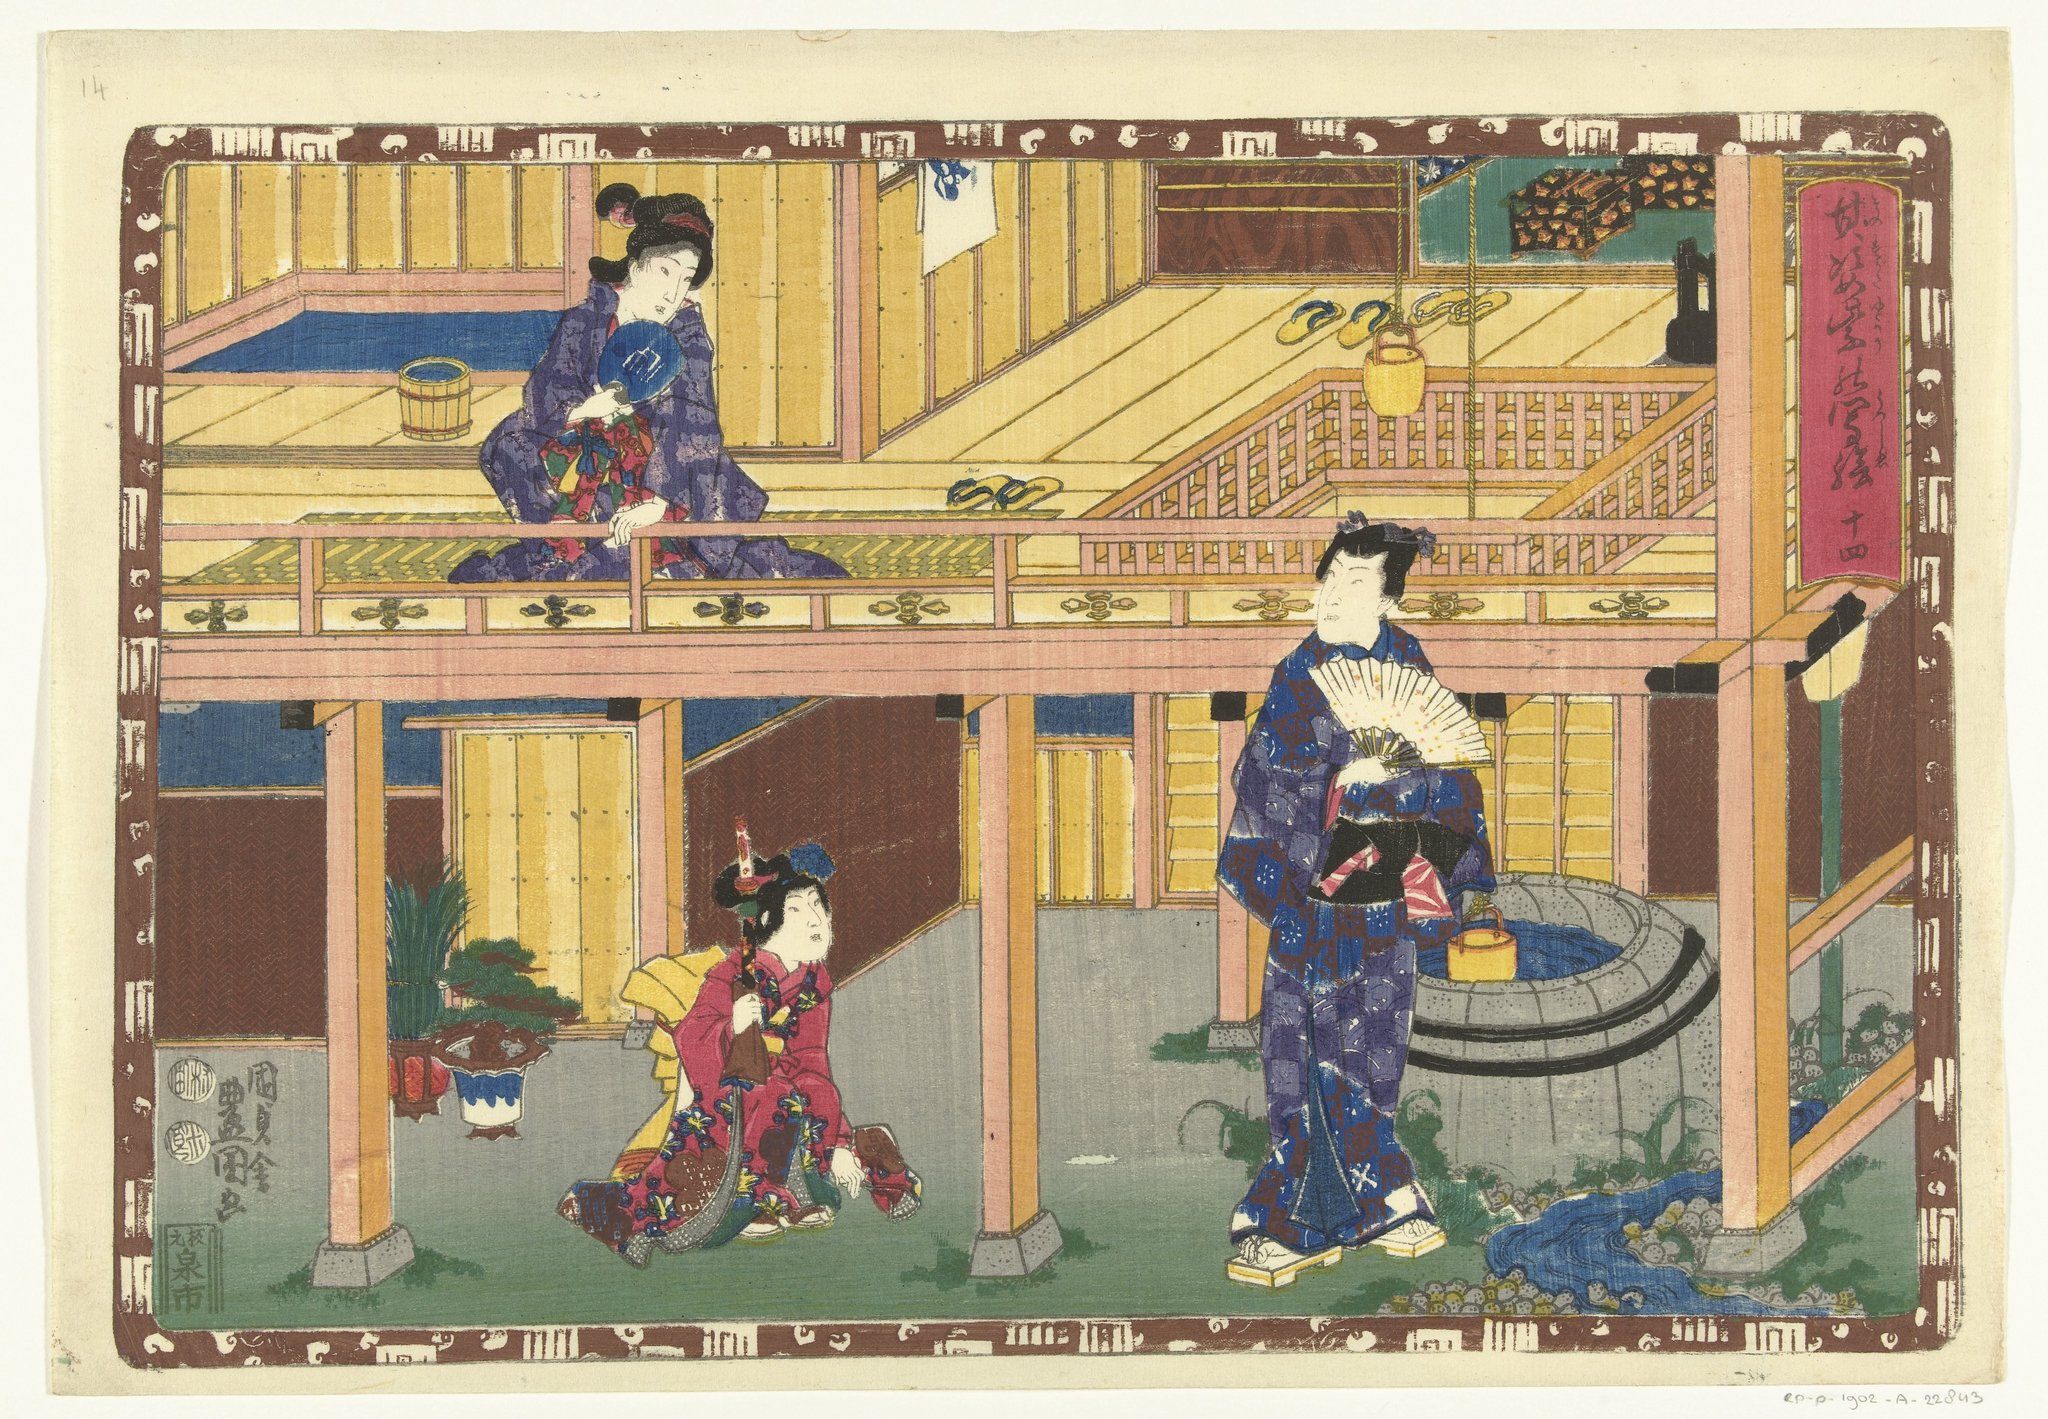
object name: print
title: Hoofdstuk 14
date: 1847-1850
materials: paper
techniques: woodcut, nishiki e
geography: japan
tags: well, prince, loggia, verandah, porch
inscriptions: collector's mark: Lugt 2228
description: Prins Genji met waaier staand bij waterput, kijkend naar vrouw zittend op veranda van eerste verdieping; een dienstmeisje met zwaard in rechter hand kijkt toe. Voorstelling omsloten door bruine rand waarin Genji emblemen.